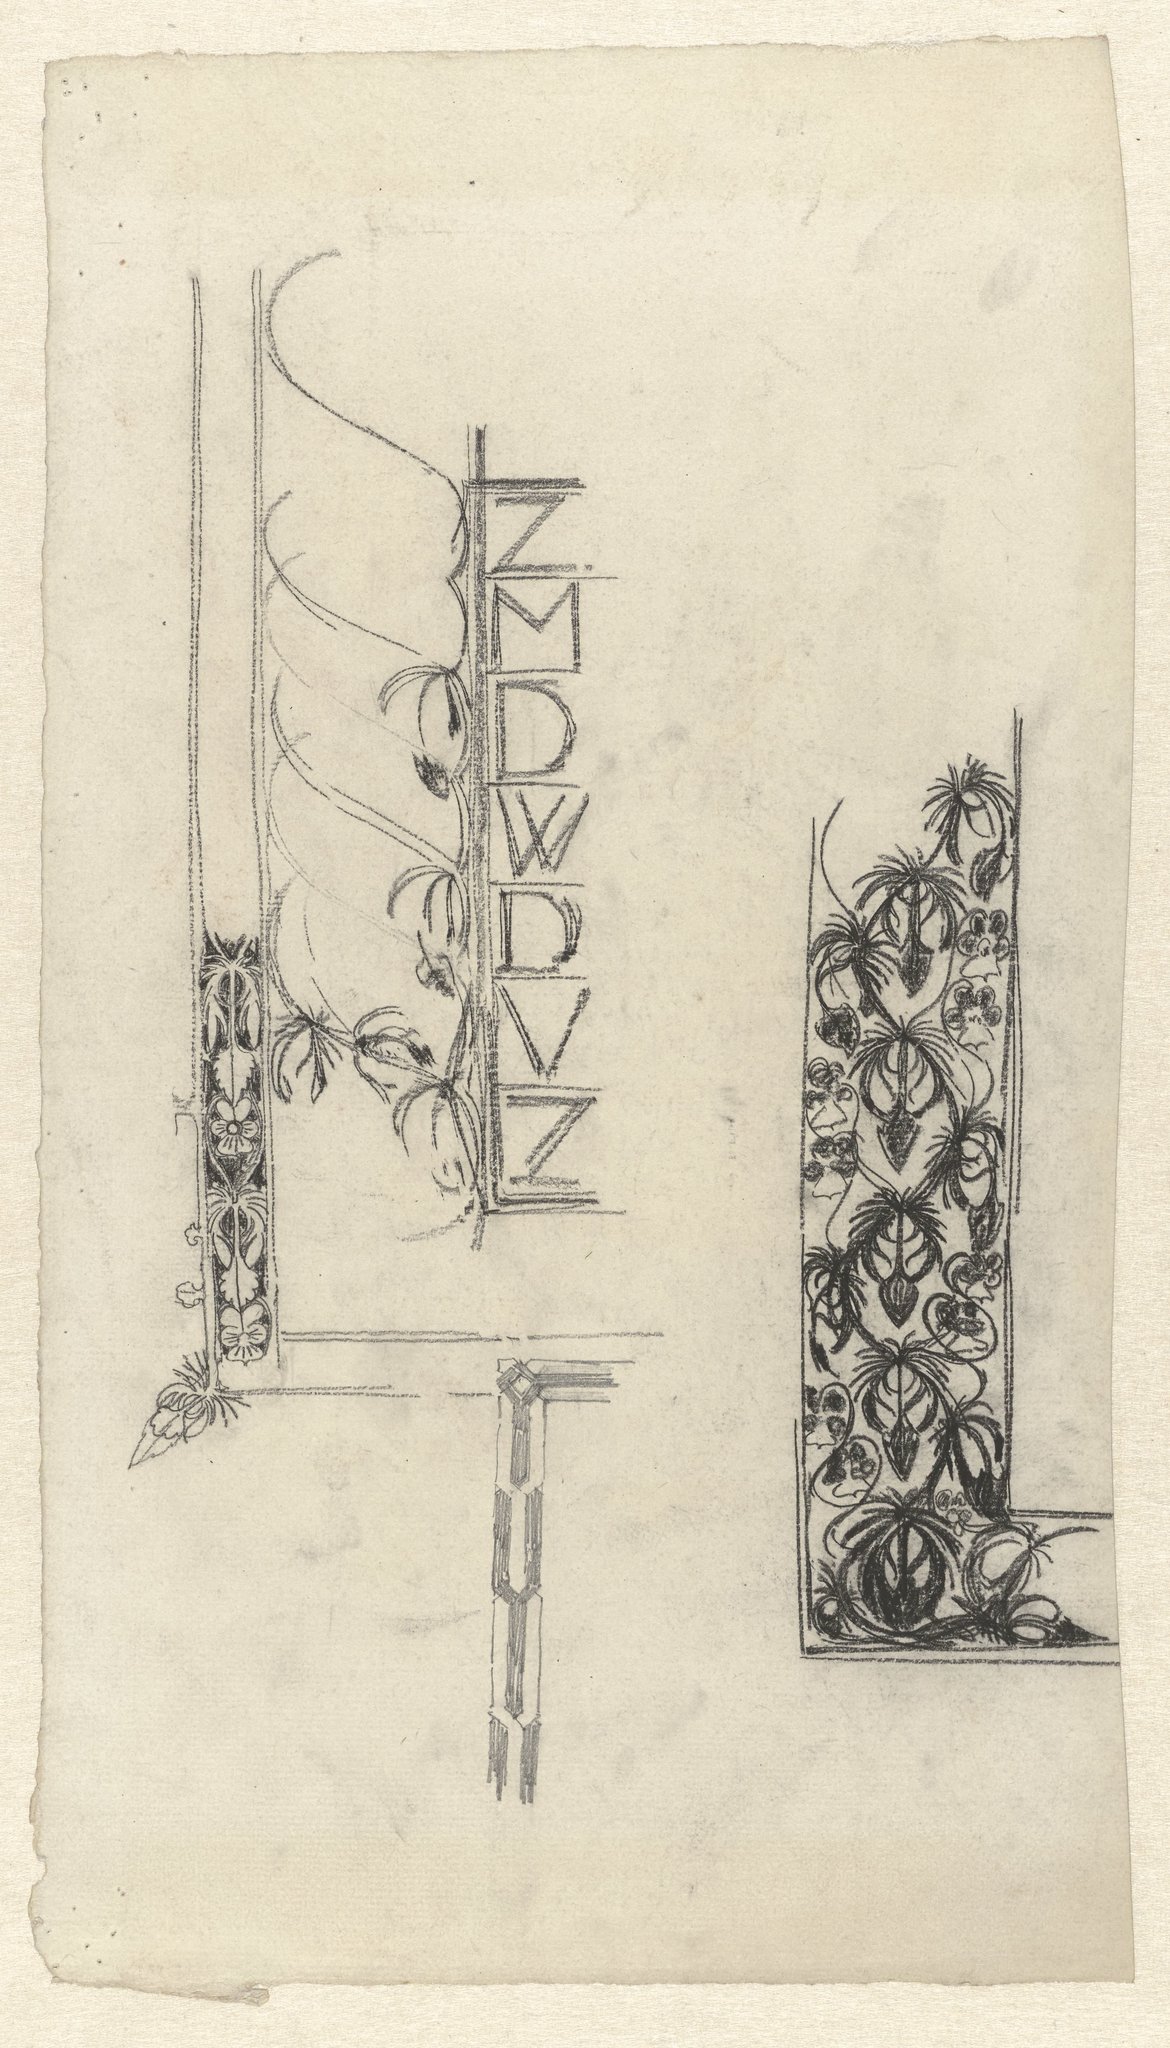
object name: drawing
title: Ontwerp voor kalender van 1901: ornamentale randwerk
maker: gerrit willem dijsselhof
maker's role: designer, draughtsman, print maker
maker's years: 1866-1924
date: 1876-1924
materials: chalk, paper, pencil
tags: ornament derived from plant forms